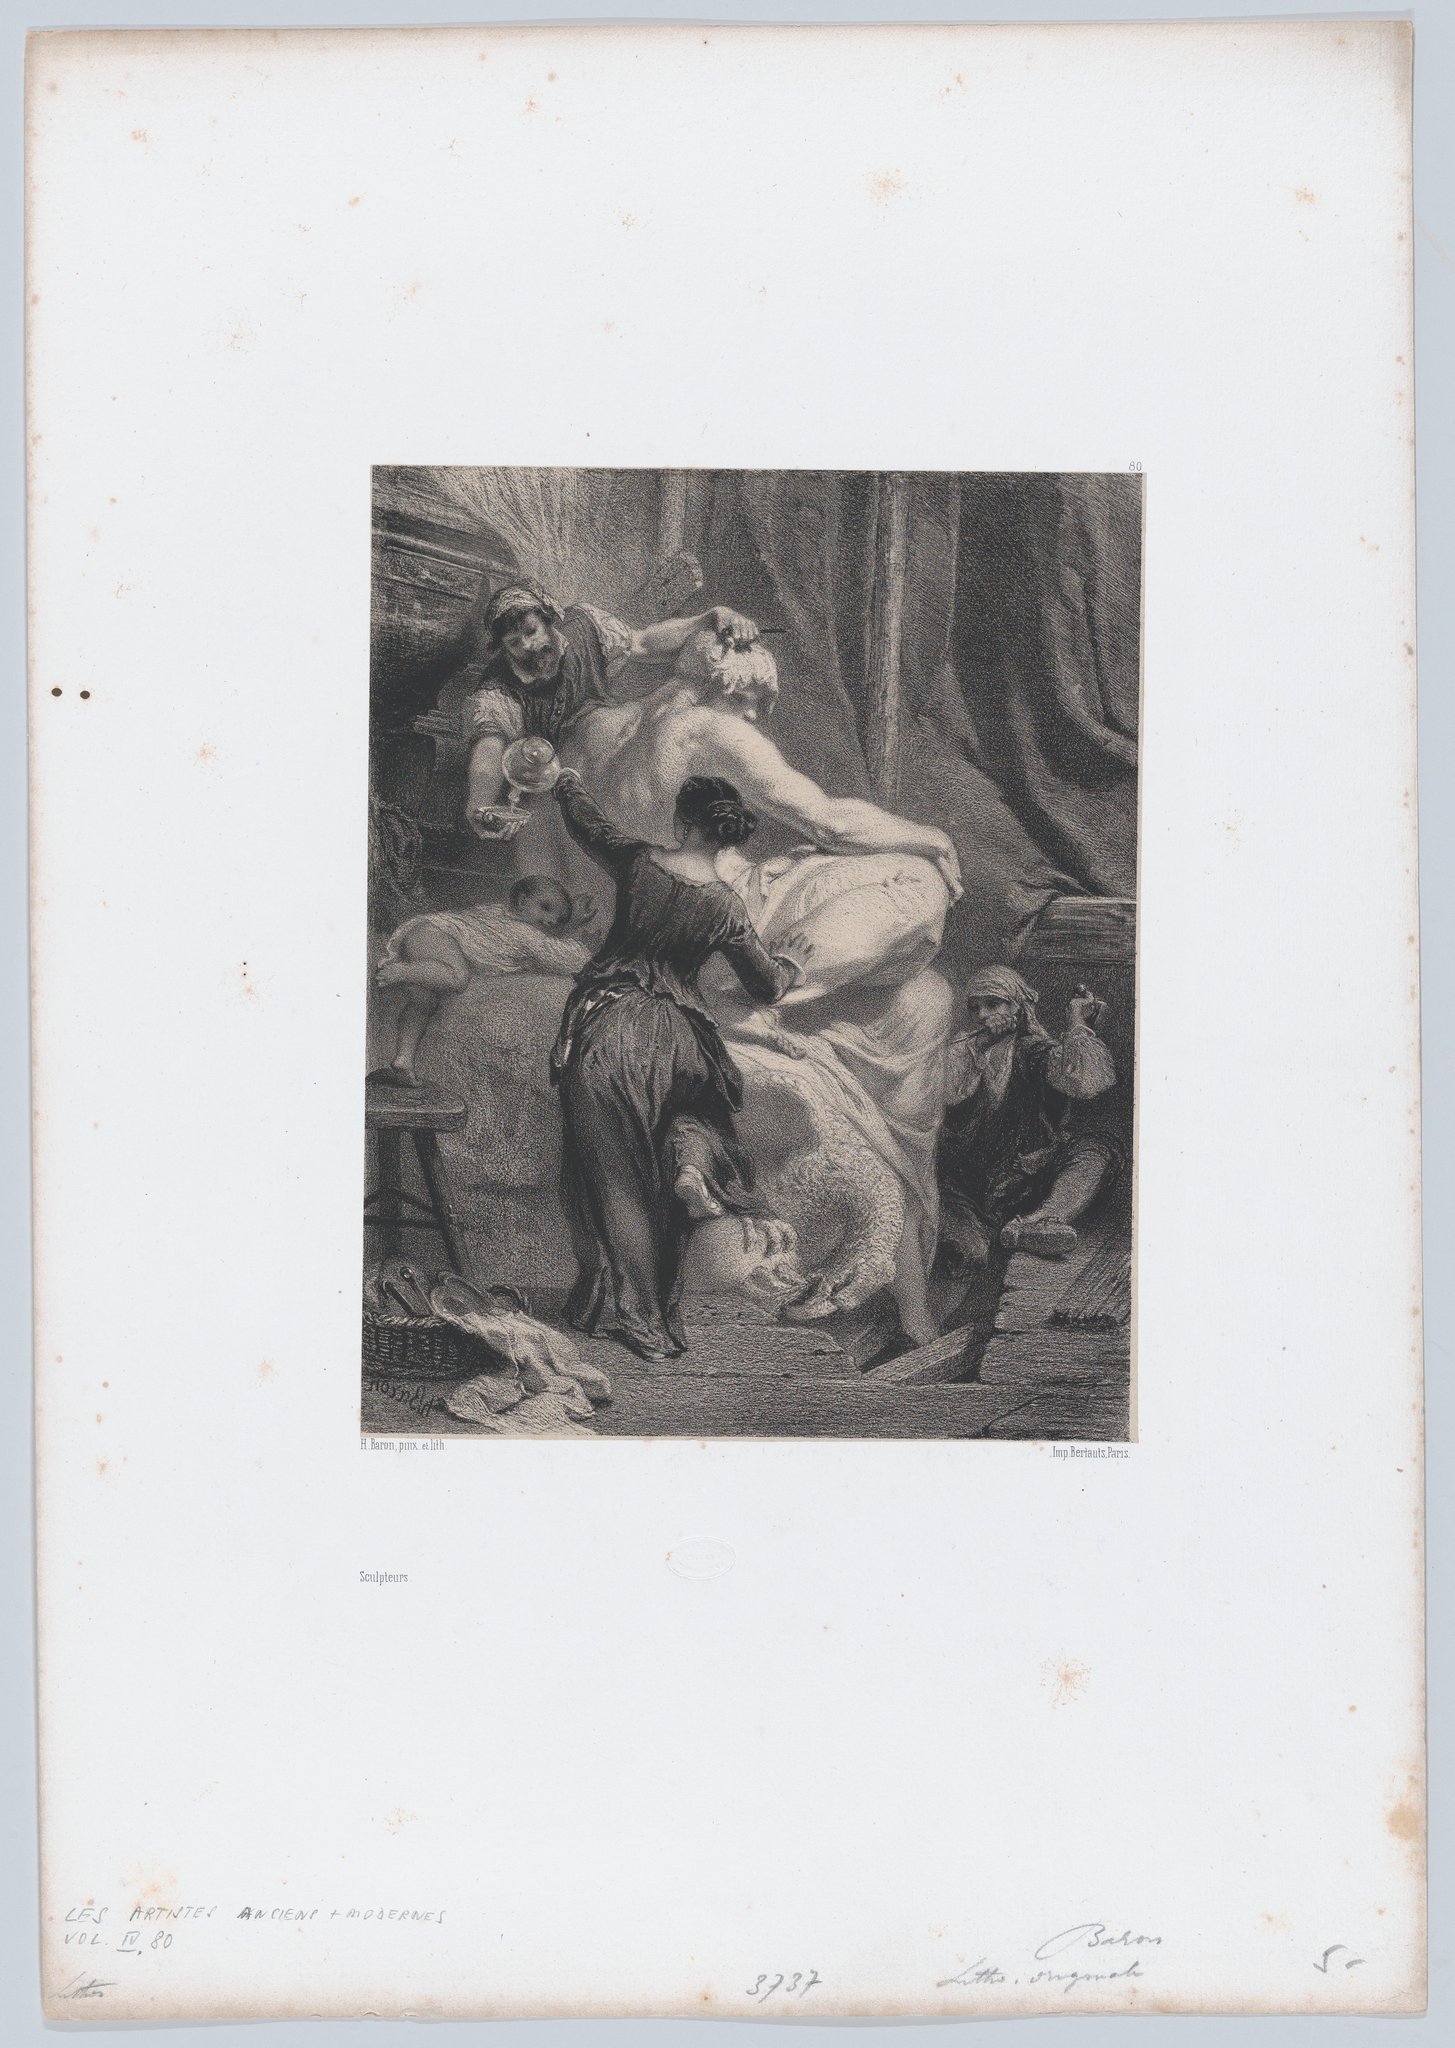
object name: print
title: Sculptors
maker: henri-charles-antoine baron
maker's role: artist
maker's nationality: french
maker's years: 1816-1885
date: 1853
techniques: lithograph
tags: sculpture,children,men,women,artists